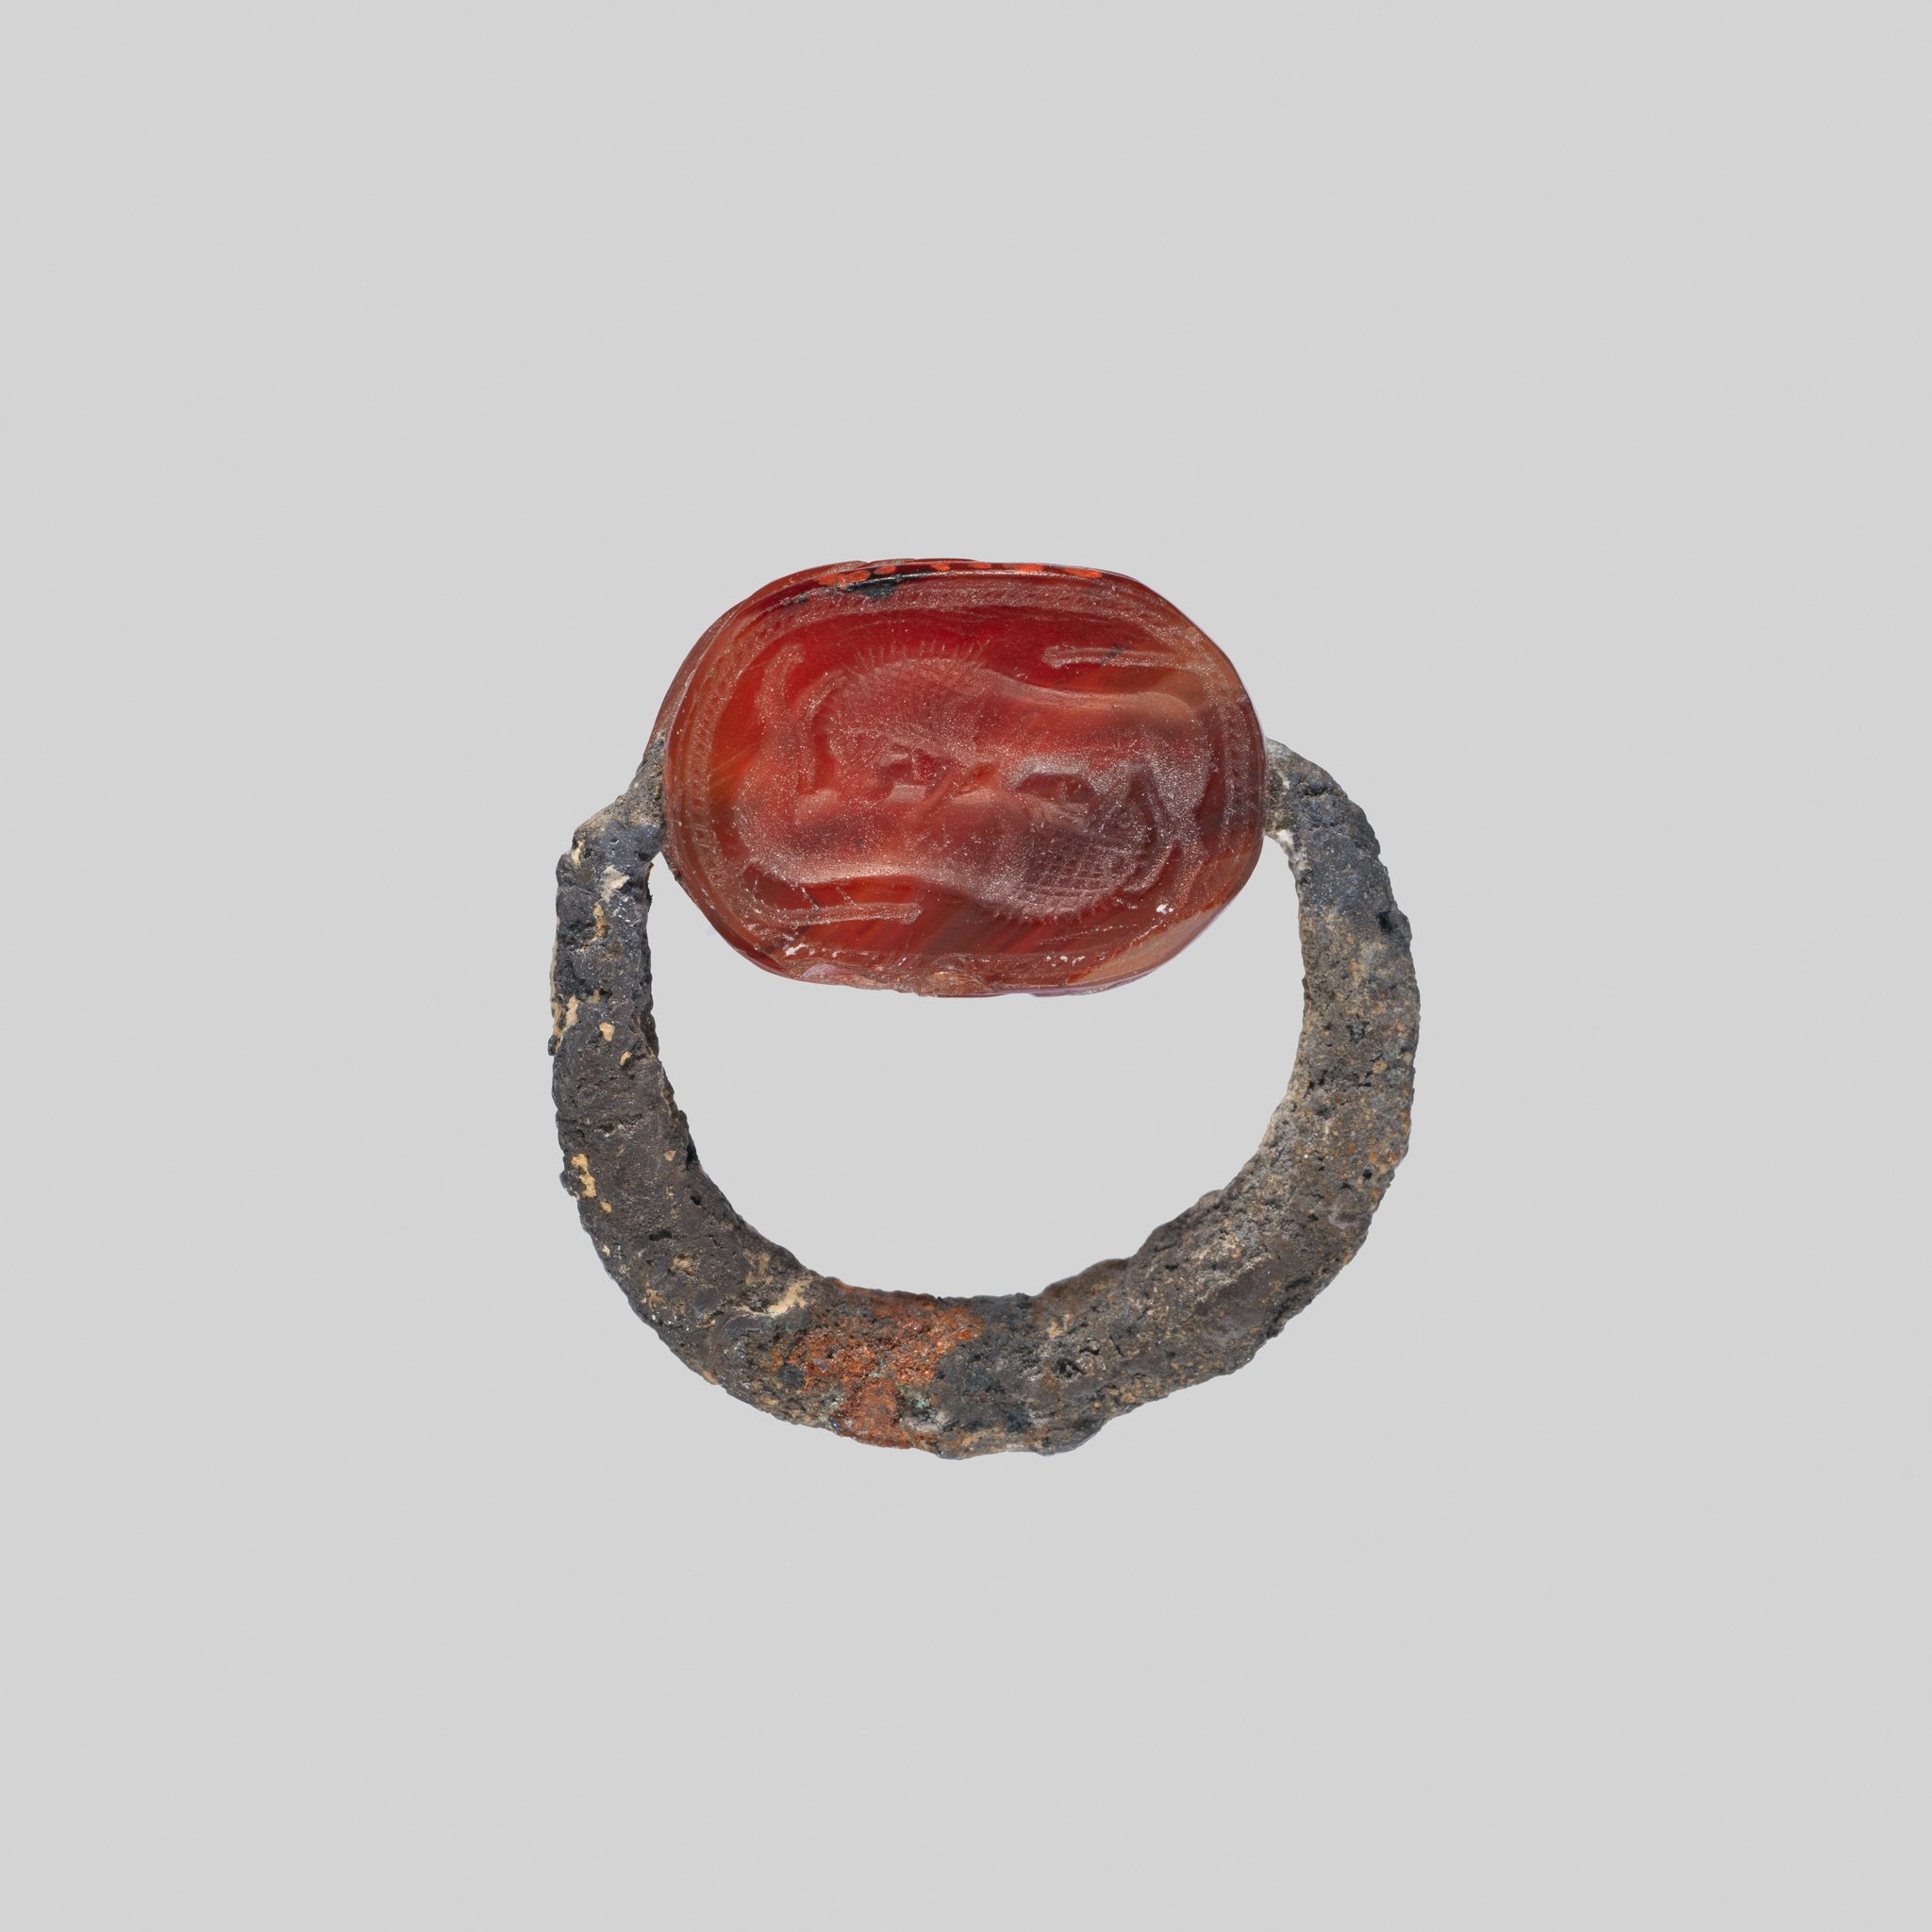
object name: ring with scarab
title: Silver ring with carnelian scarab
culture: greek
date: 550-501 BCE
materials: gemstone, silver